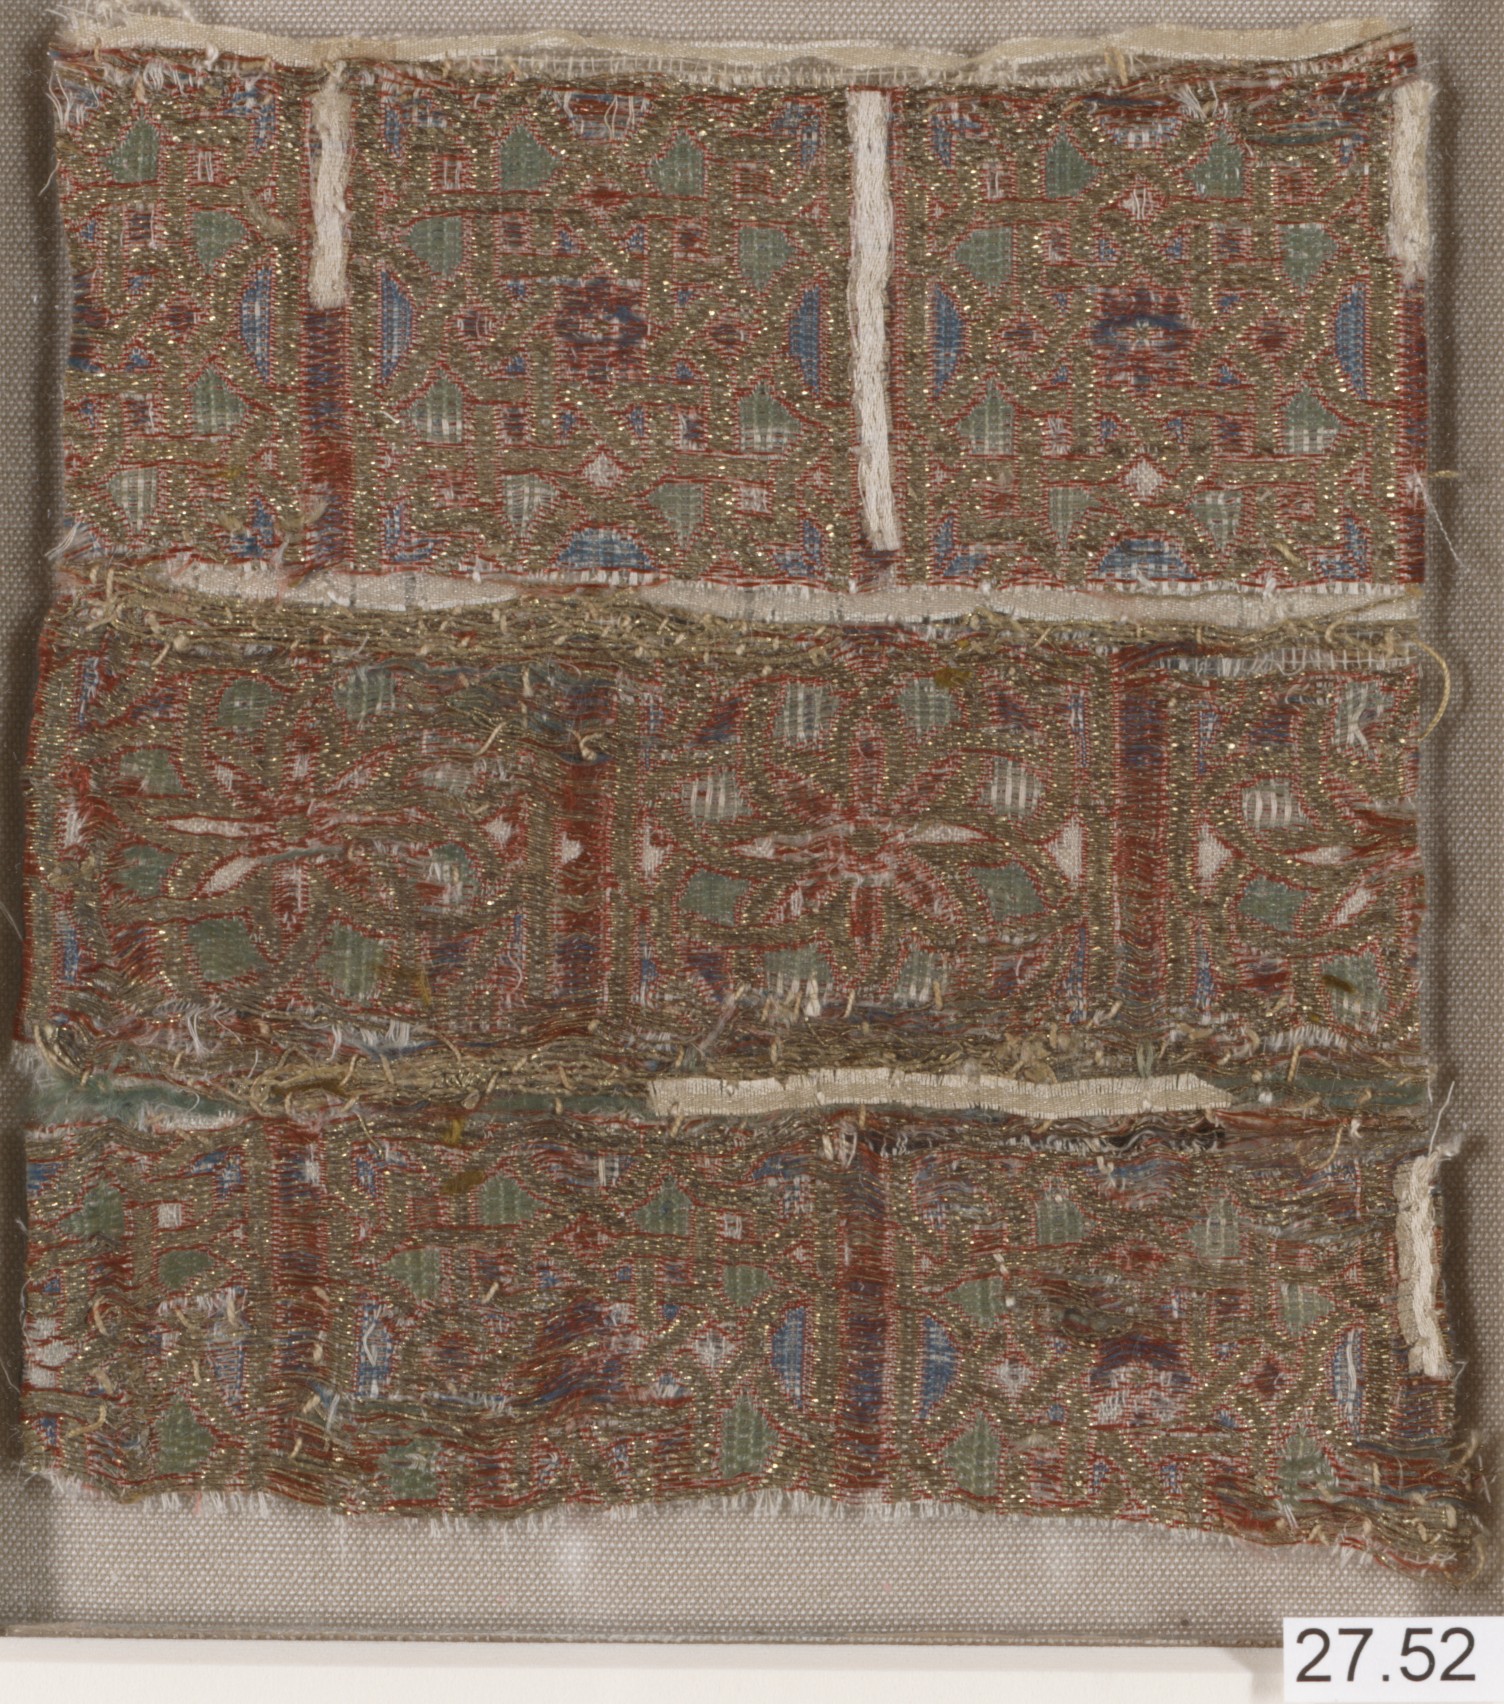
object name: fragment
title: Textile Fragment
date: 1701-1750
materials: metal thread, silk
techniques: brocade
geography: spain